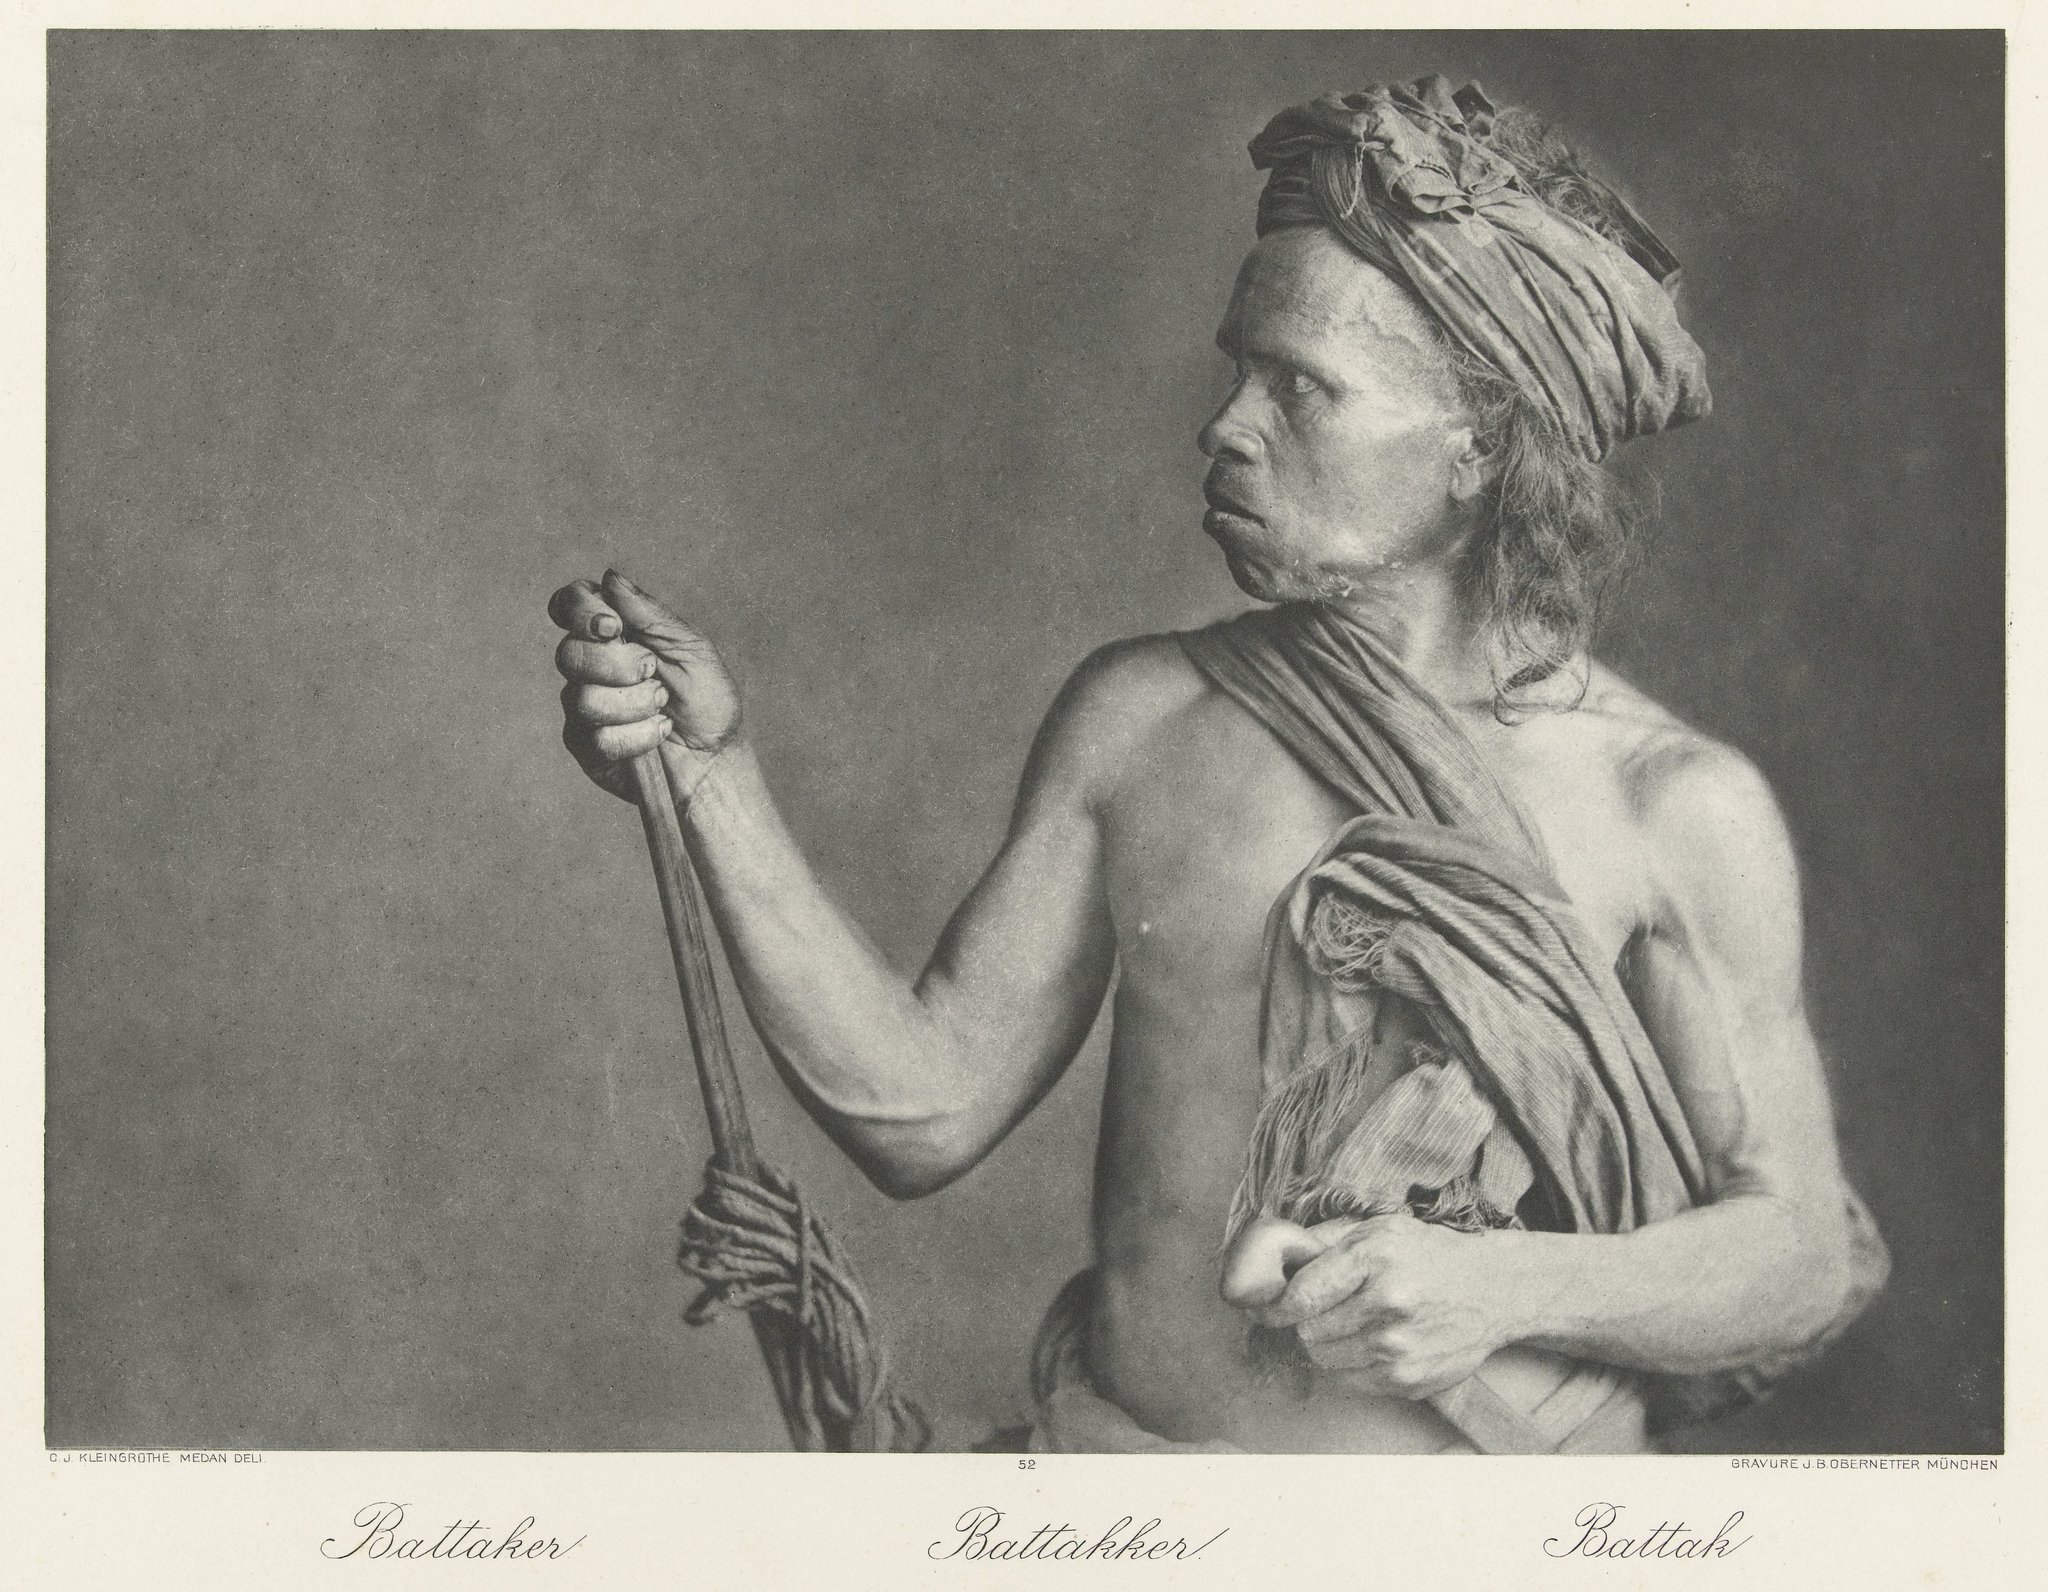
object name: photomechanical print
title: Battakker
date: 1883-1887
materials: paper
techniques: photoaquatint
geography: munich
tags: head-gear, hacking and thrusting weapons: dagger, adult man, sumatra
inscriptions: number: ‘52’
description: Onderdeel van Album met heliogravures van Sumatra's oostkust.